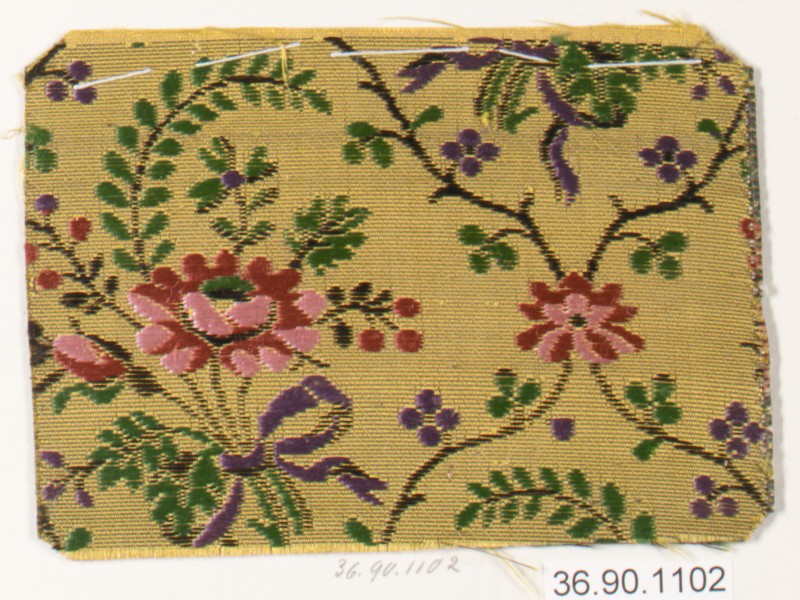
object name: sample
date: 1701-1900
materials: metal thread, silk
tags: flowers